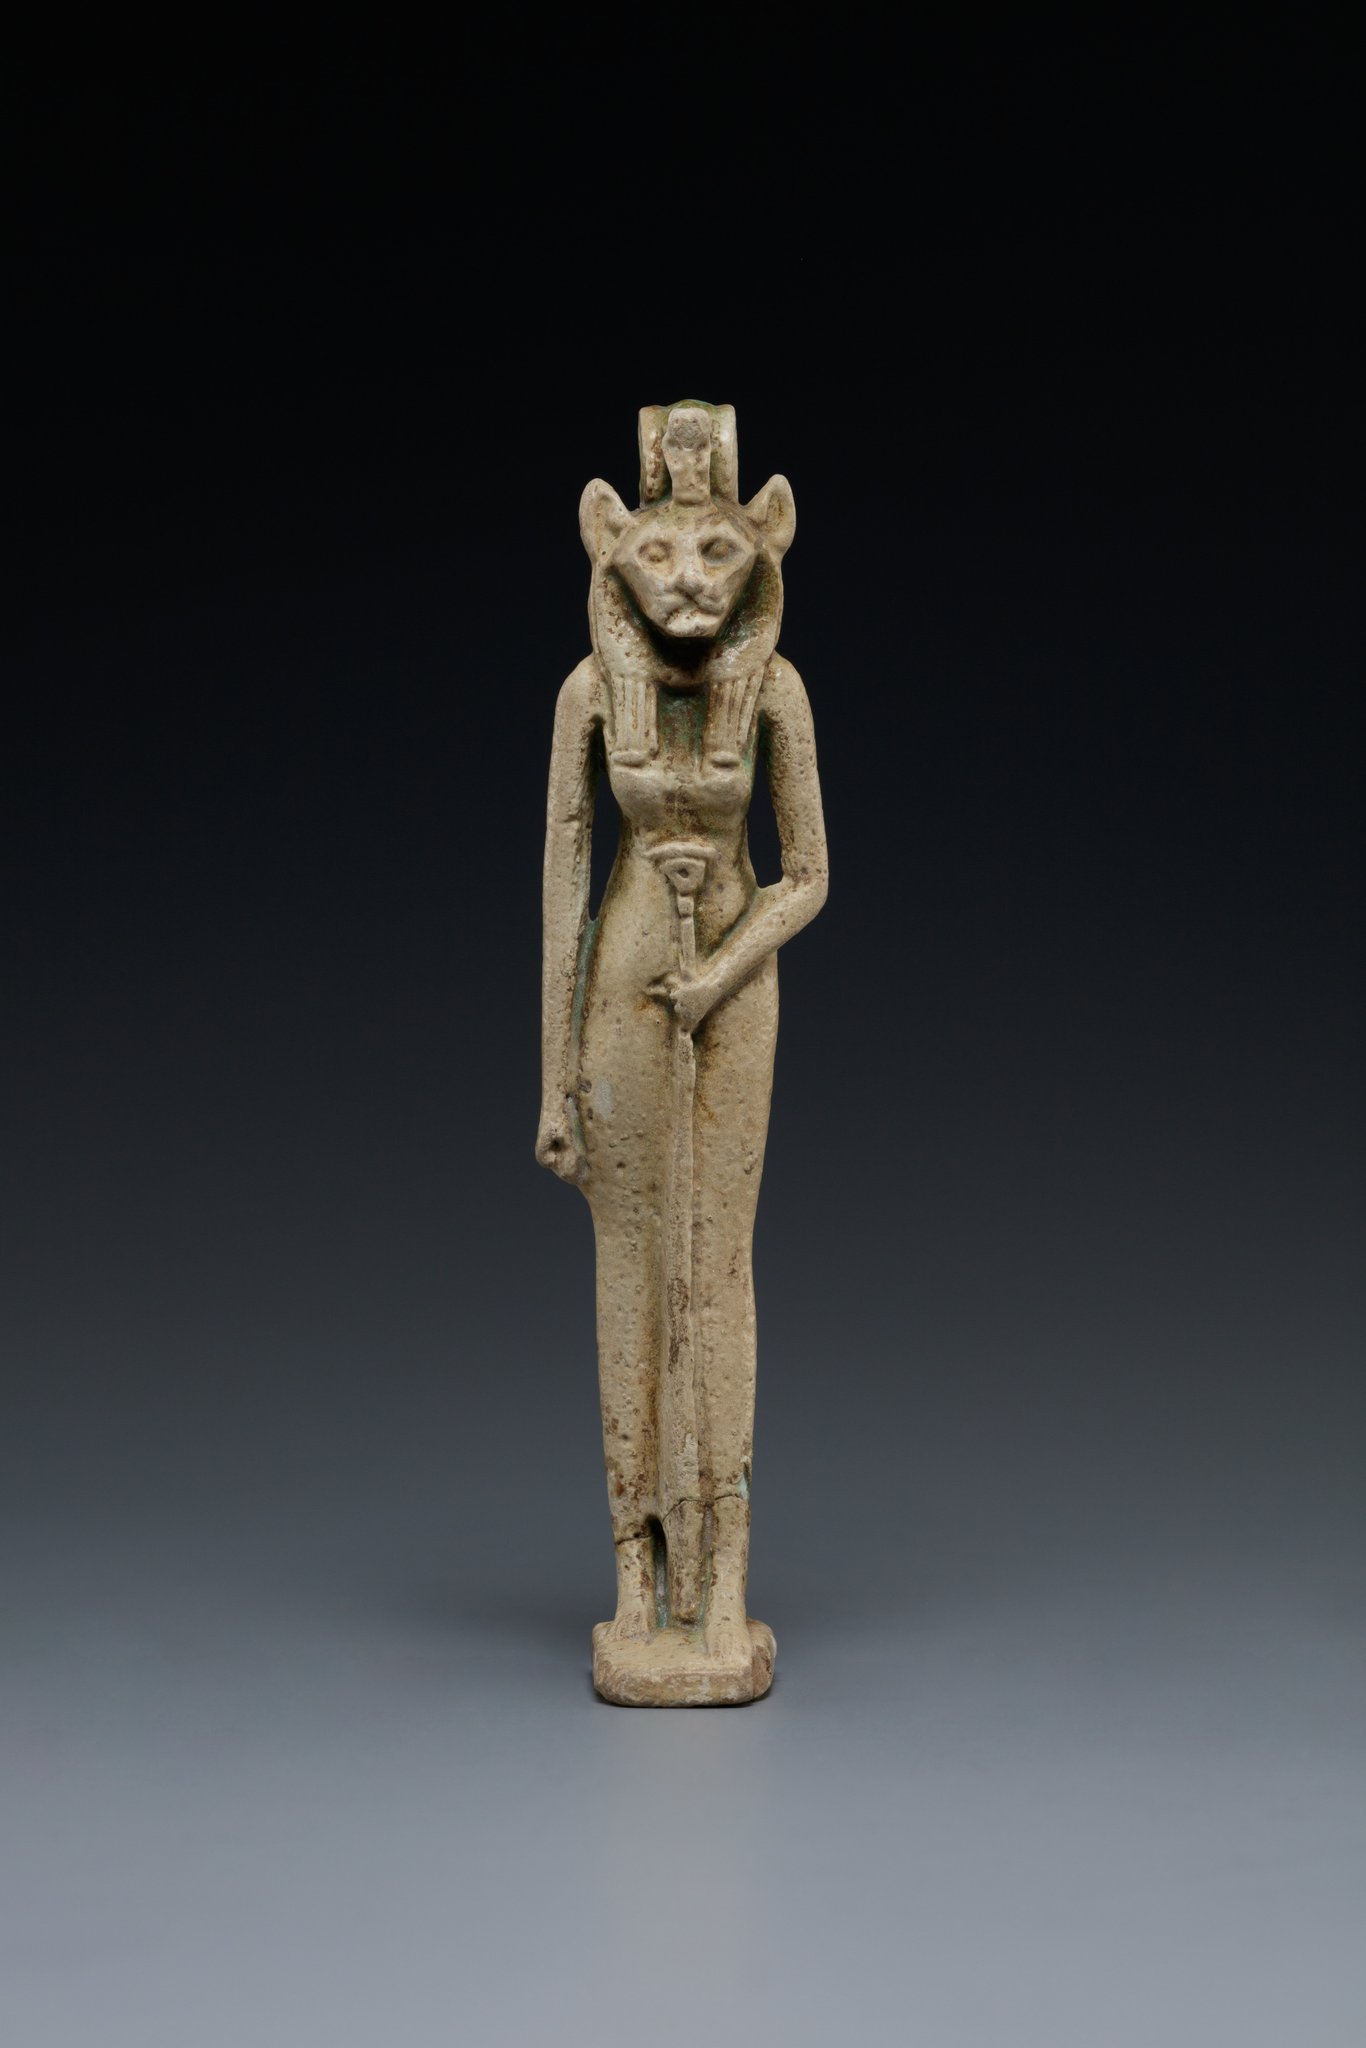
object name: amulet, sakhmet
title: Sakhmet Amulet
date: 664-630 BCE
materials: faience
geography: egypt